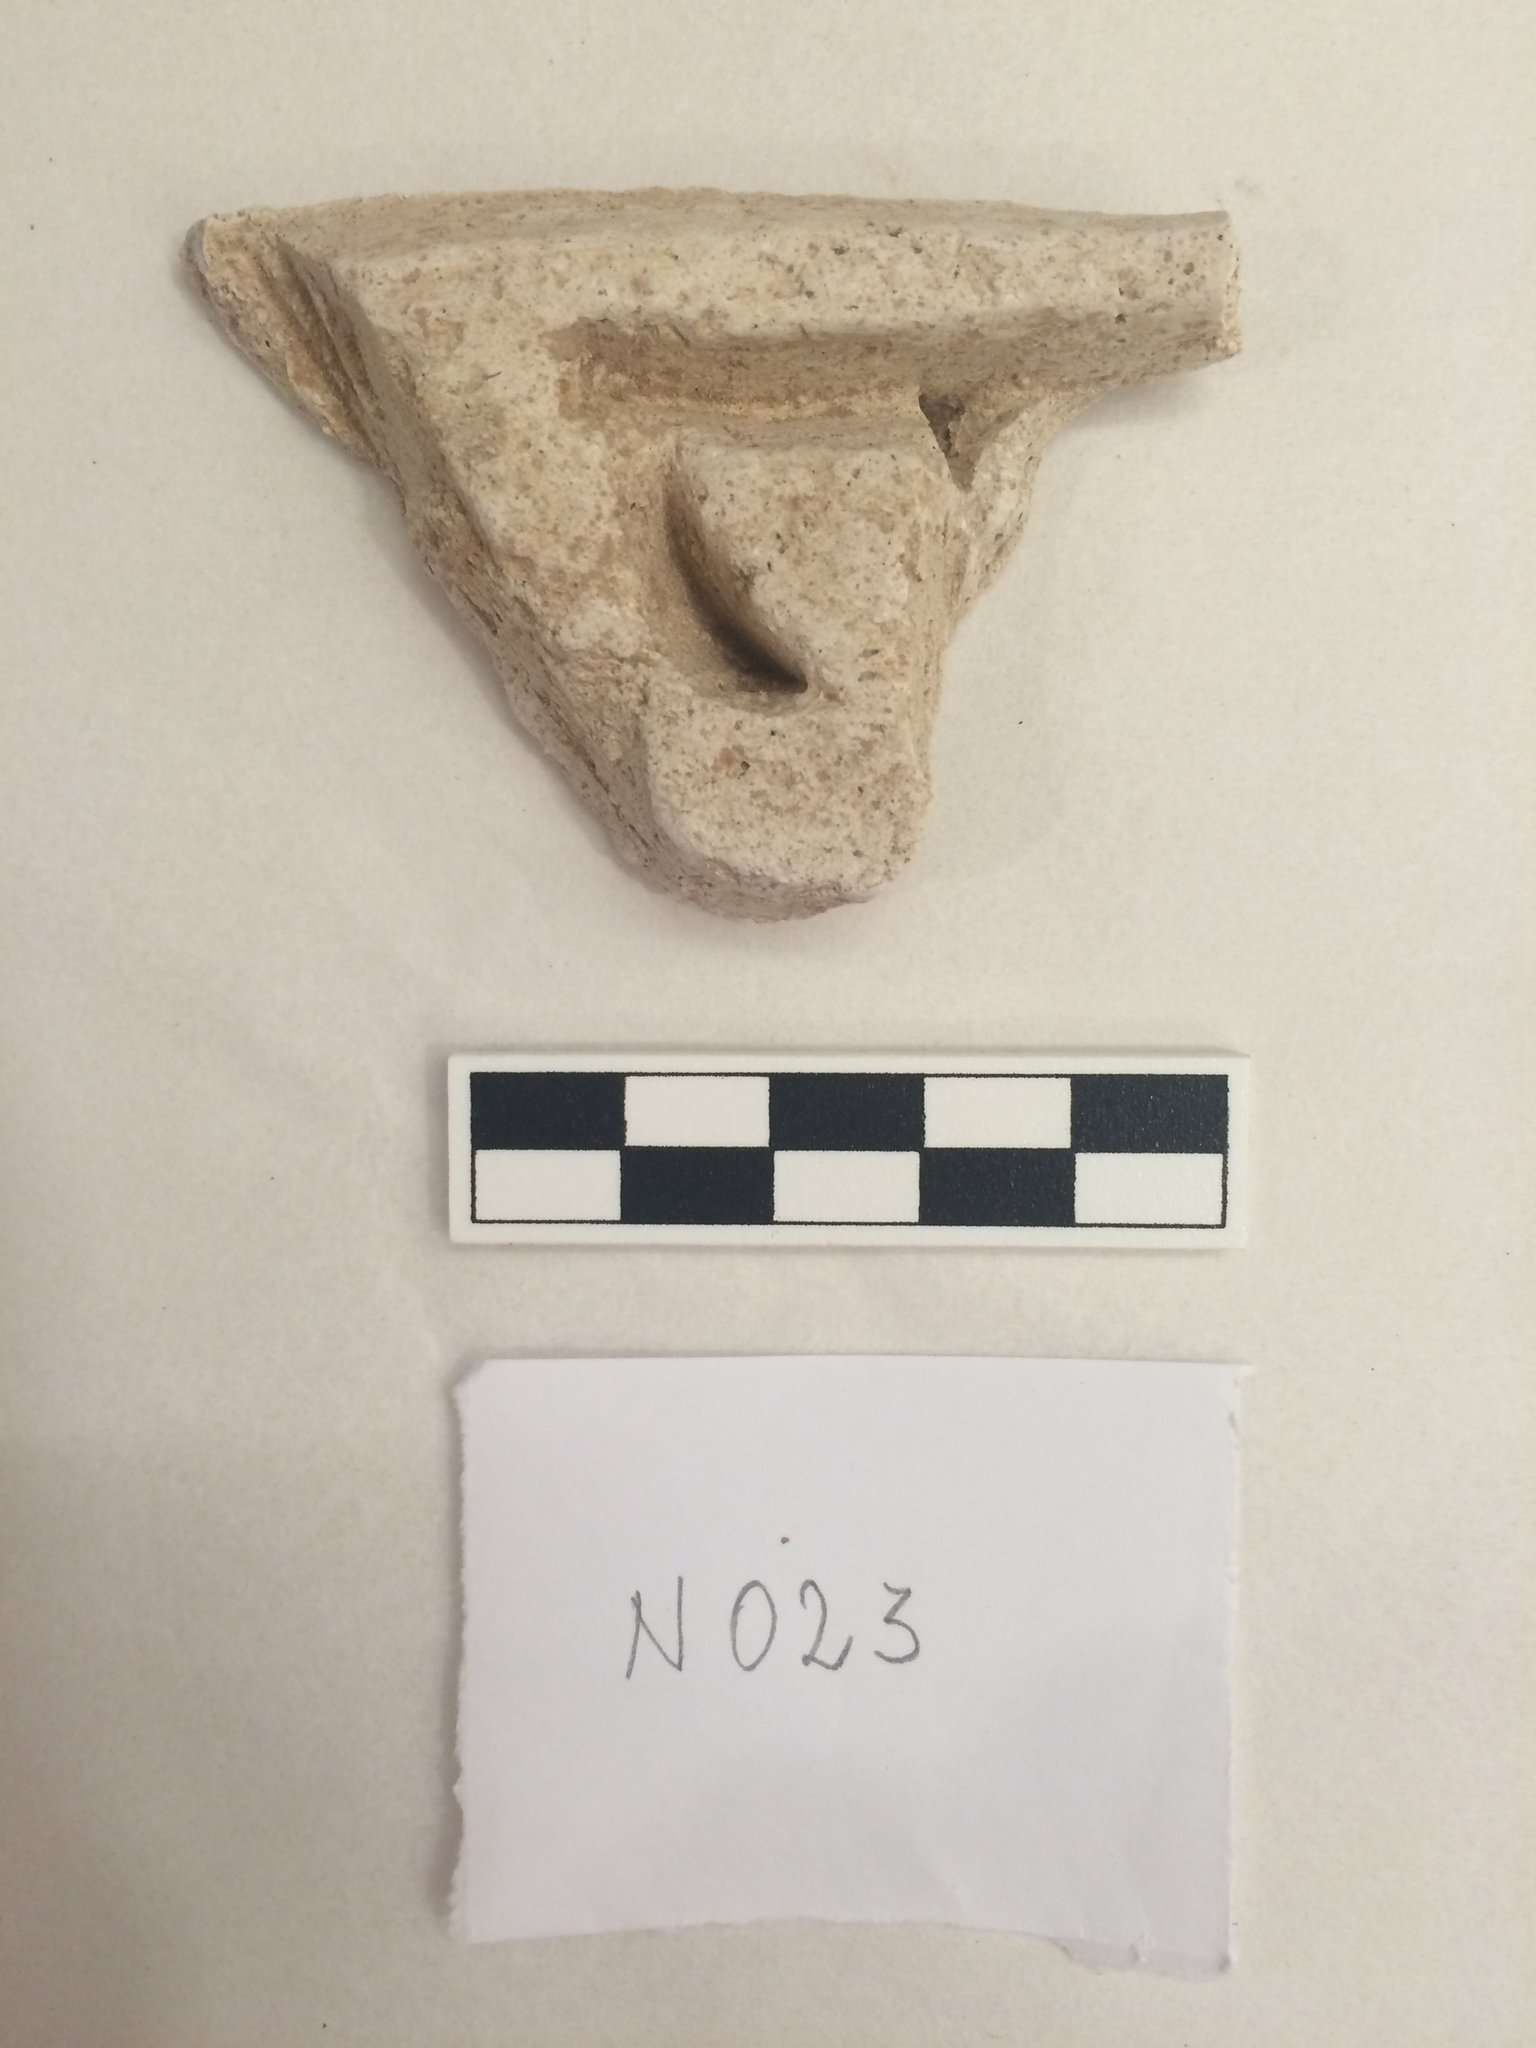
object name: fragment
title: Stucco Fragment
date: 701-1200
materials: plaster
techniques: carving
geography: iran